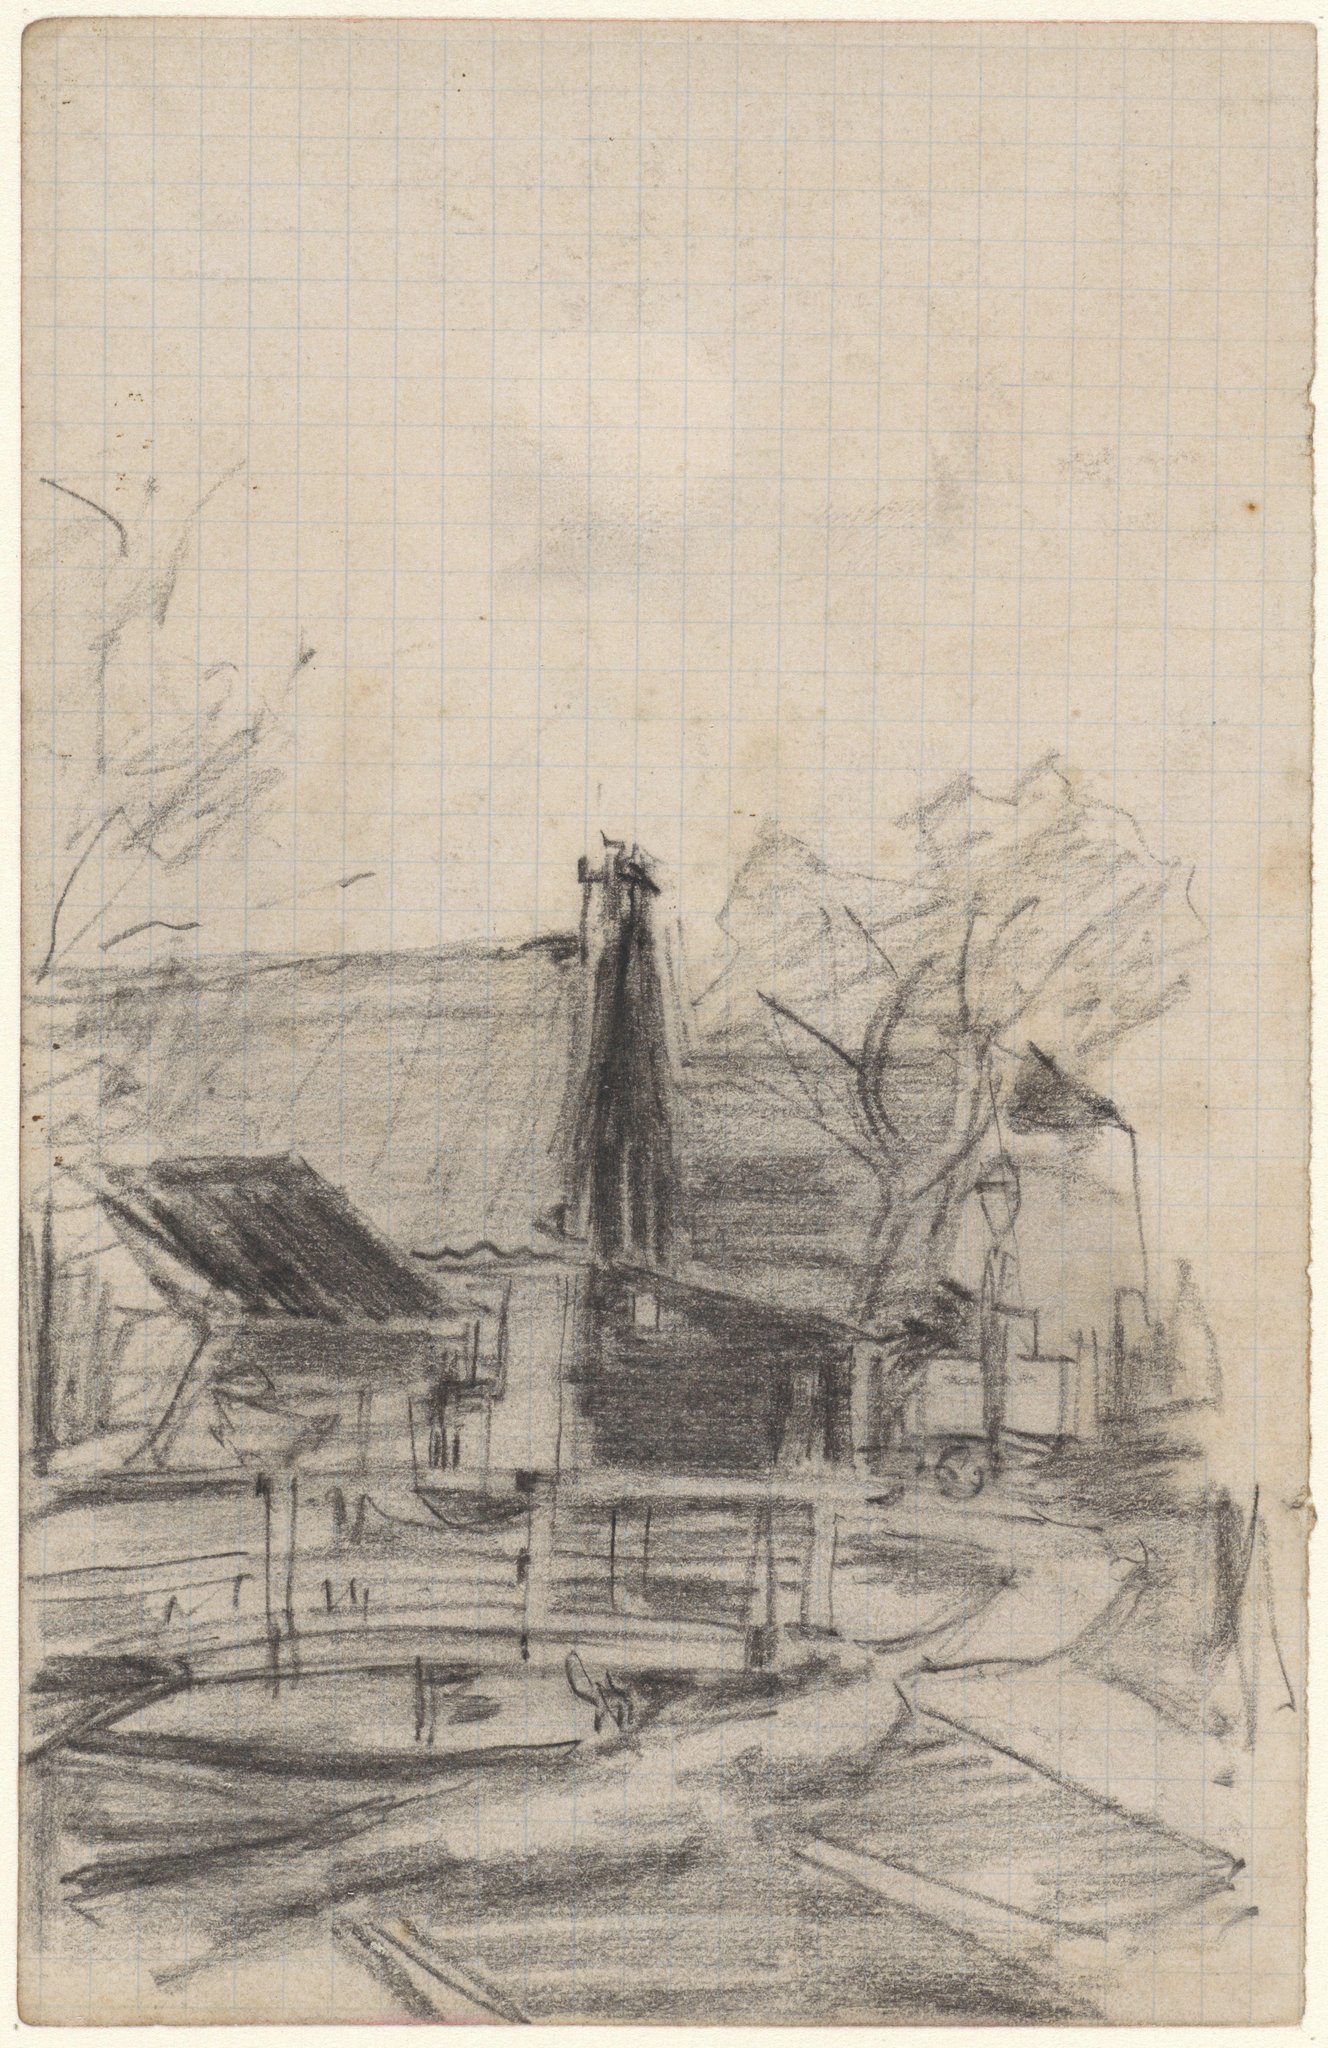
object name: drawing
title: Dorpshuizen met een bruggetje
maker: theo nieuwenhuis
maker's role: designer, draughtsman, print maker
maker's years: 1866-1951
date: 1876-1951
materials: chalk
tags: prospect of village, silhouette of village